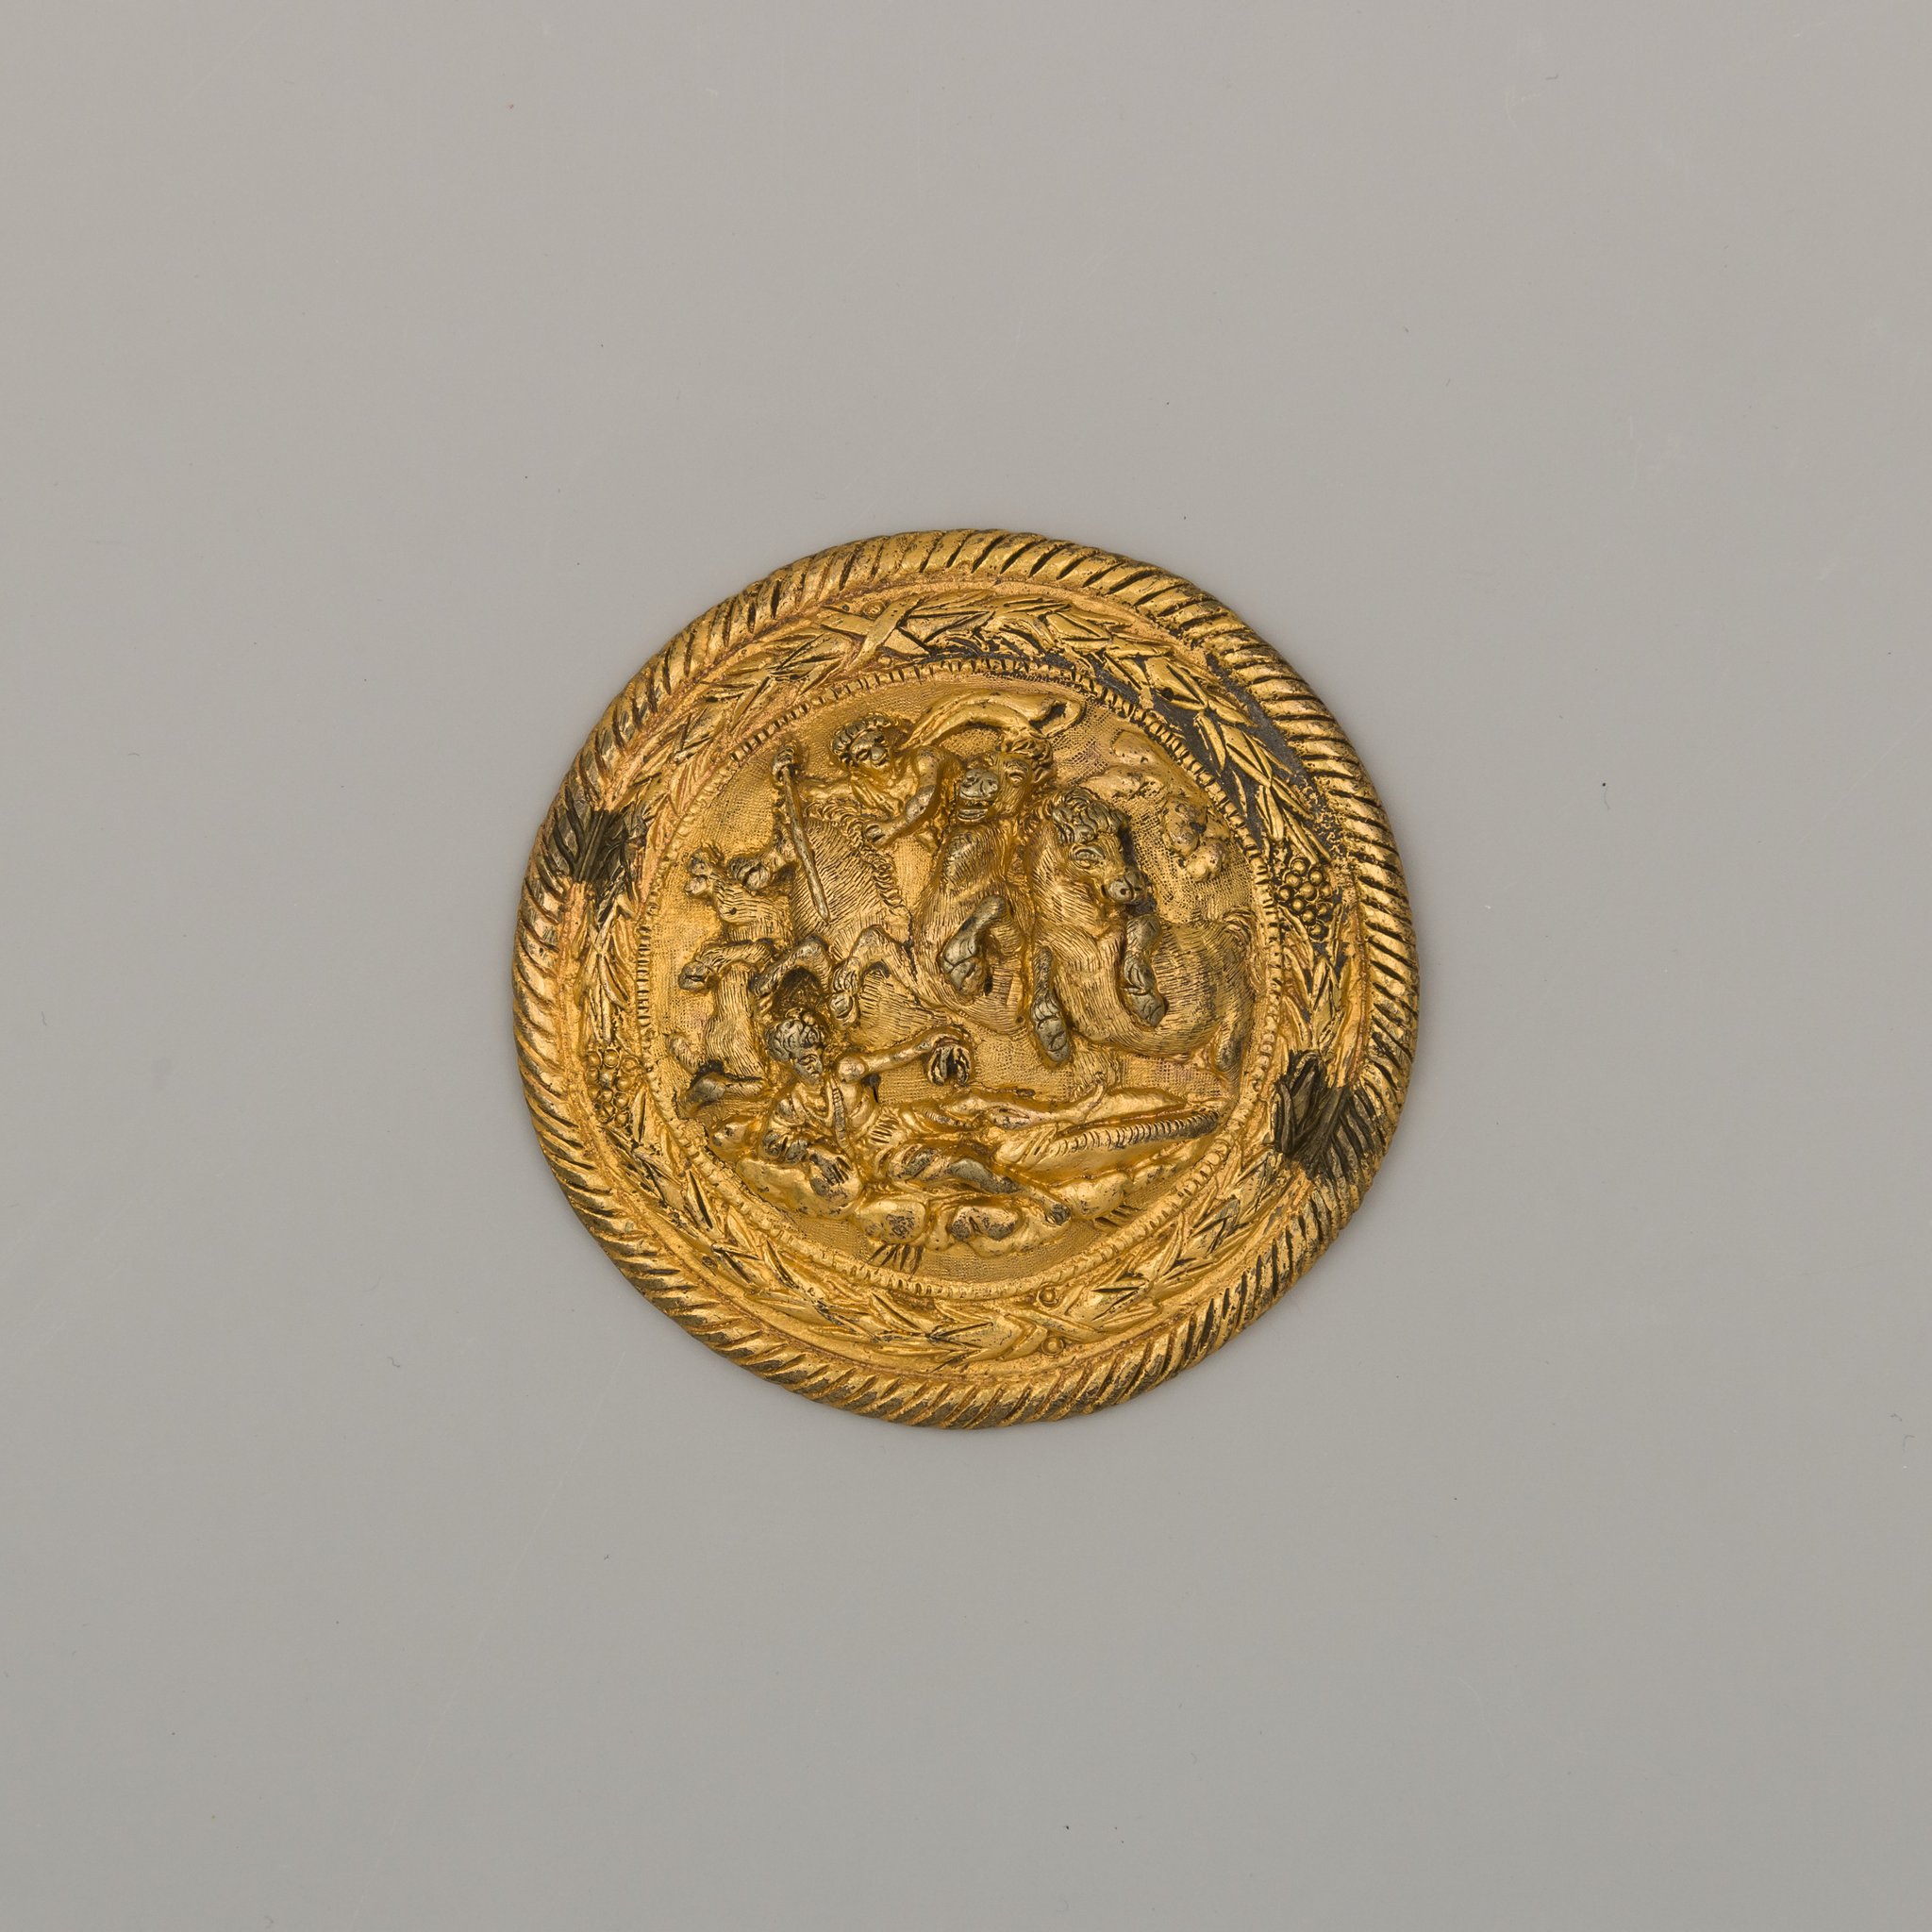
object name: bit bos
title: Bit Boss with Apollo and Aurora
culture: german, south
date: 1567-1600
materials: copper alloy, gold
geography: germany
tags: apollo,horses